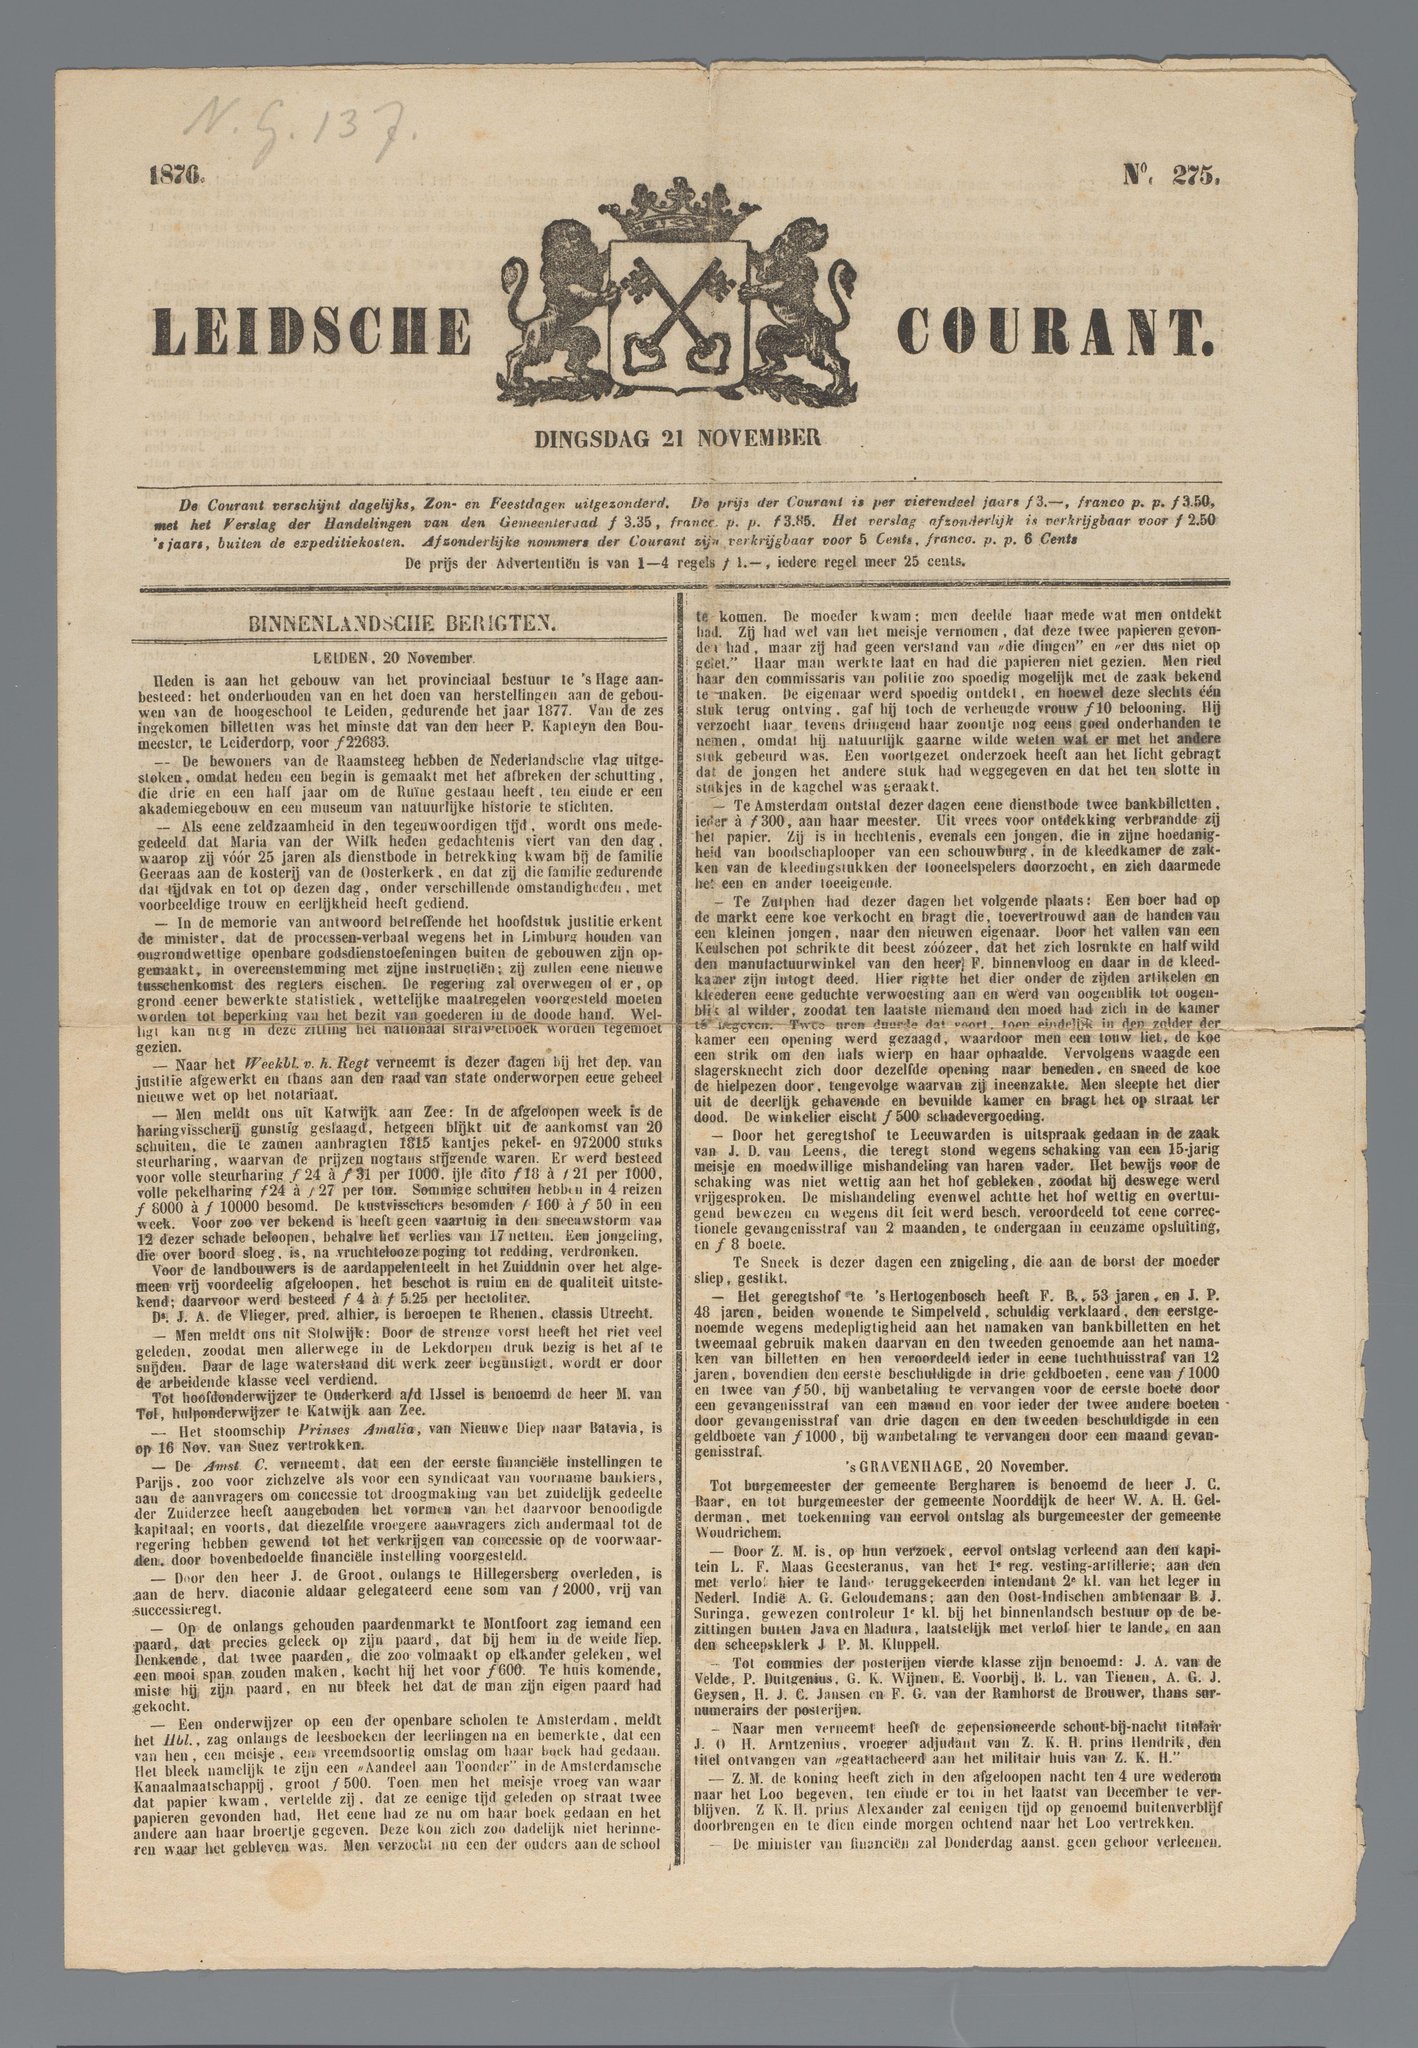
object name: newspaper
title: Leidsche Courant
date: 1876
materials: paper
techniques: printing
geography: leiden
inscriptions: date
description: Krant, bestaande uit één vel (4 pp). Leidsche courant van dinsdag 21 nov 1876, nr. 275.